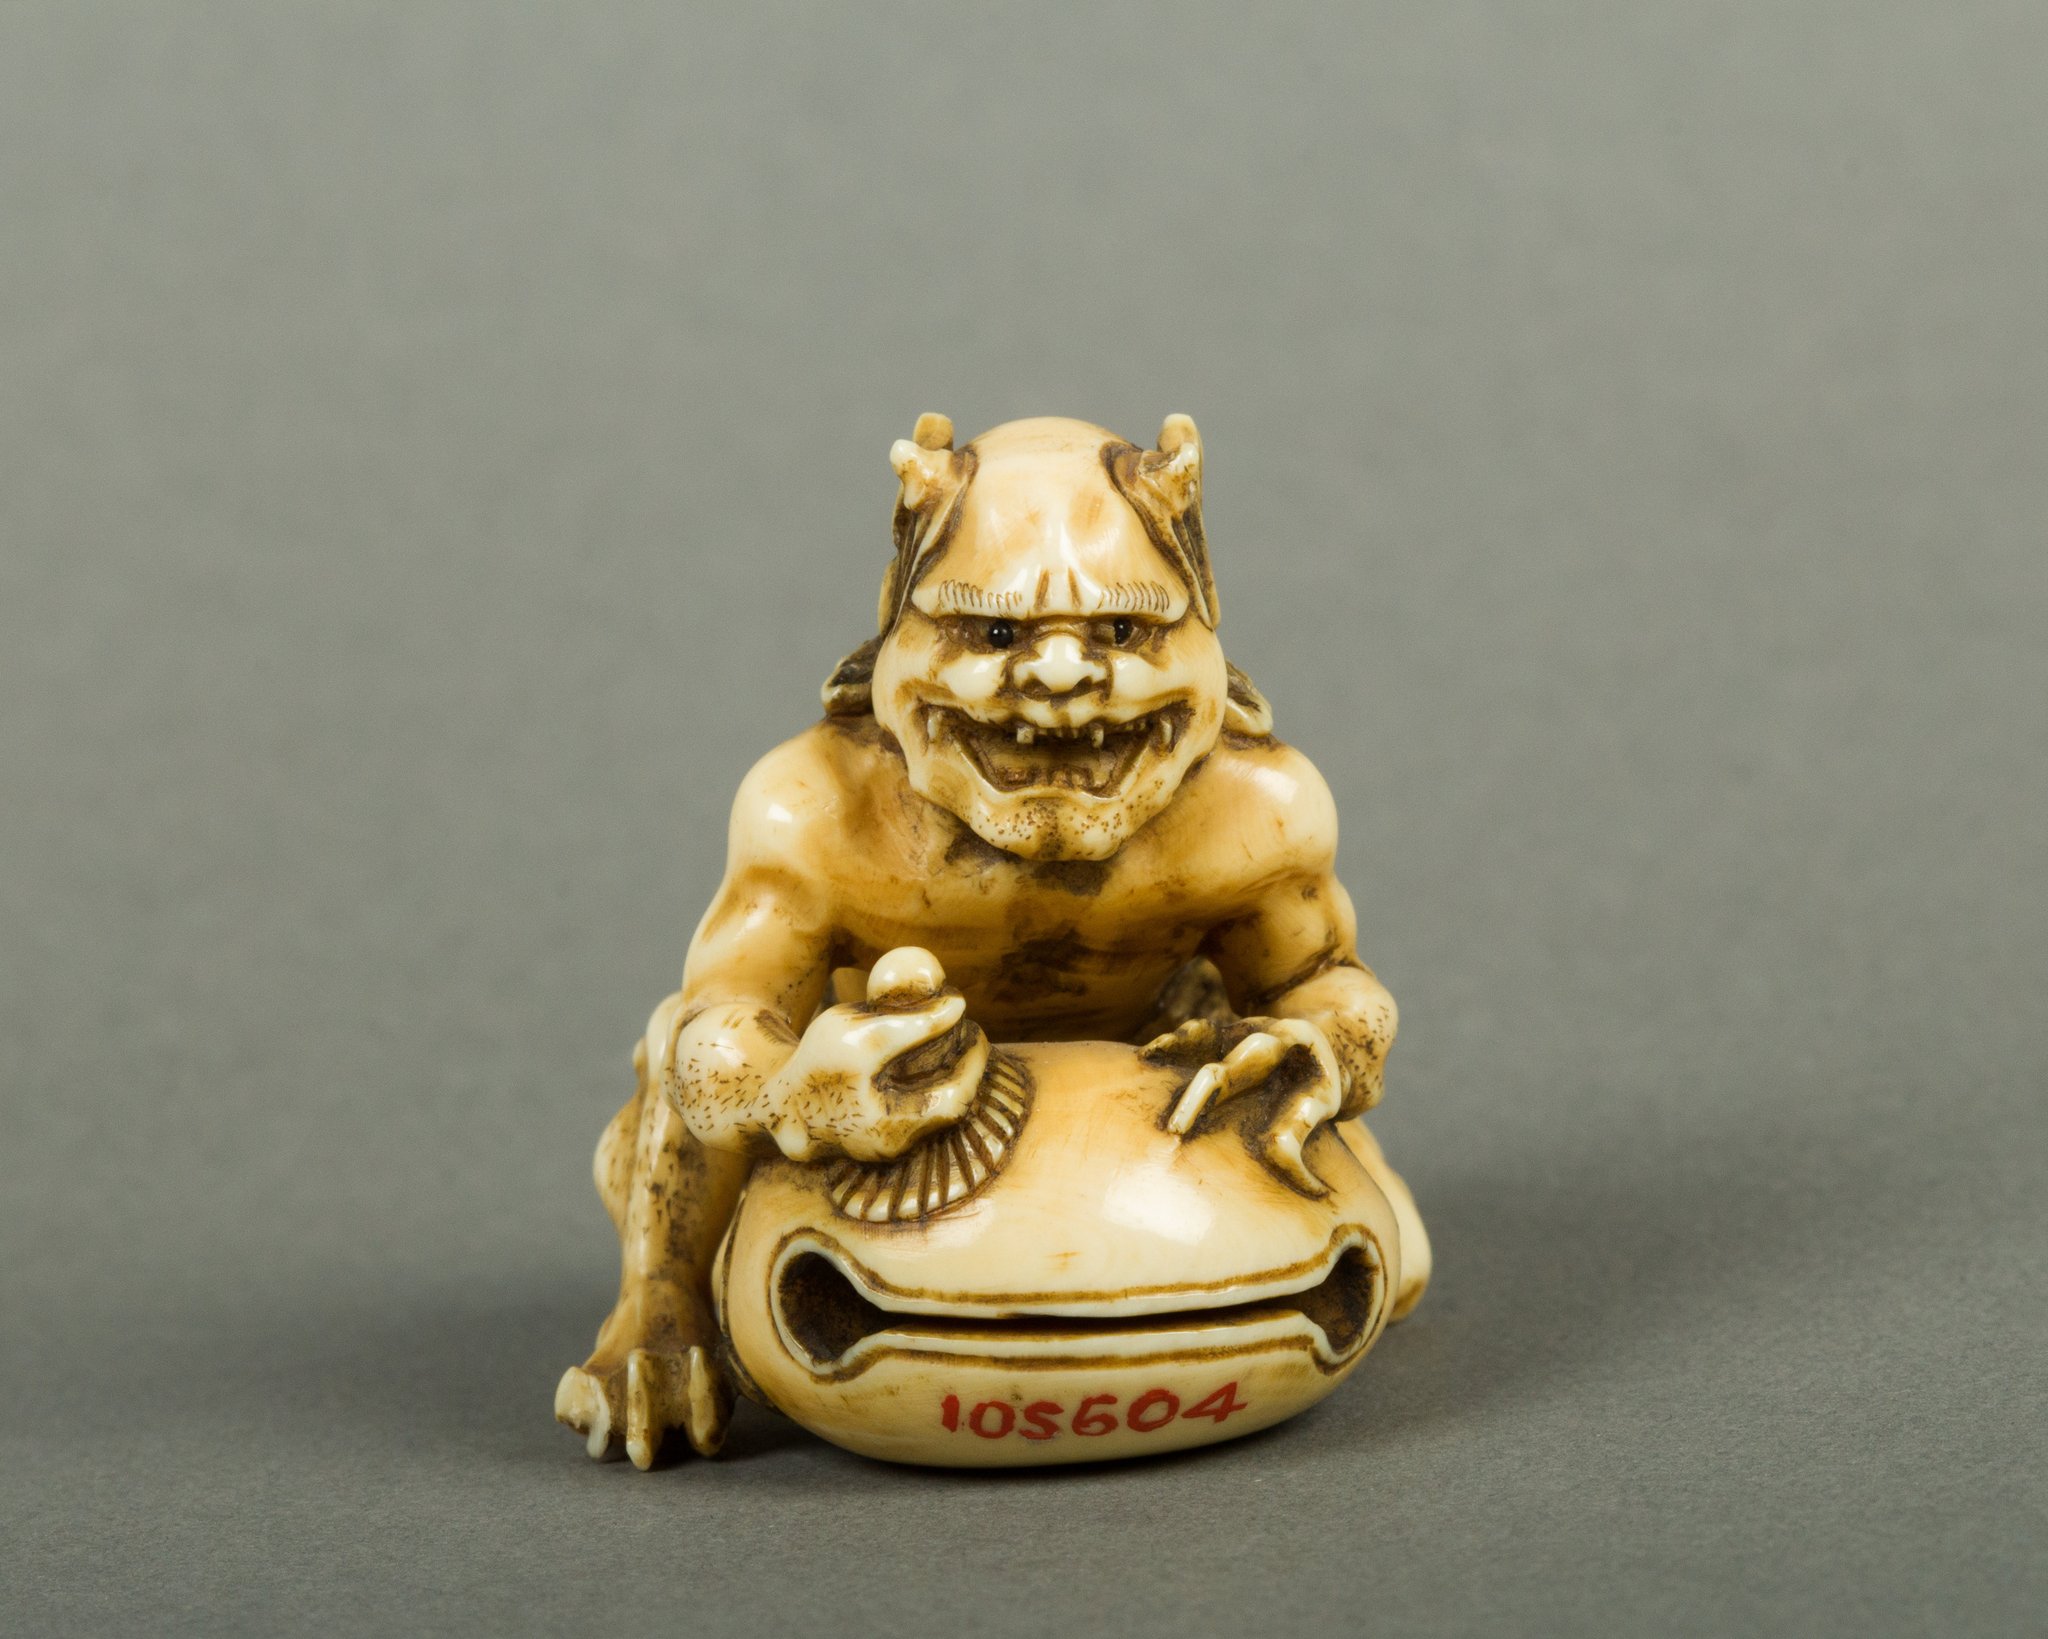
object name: netsuke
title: Netsuke of Demon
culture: japanese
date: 1801-1900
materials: ivory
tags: demons